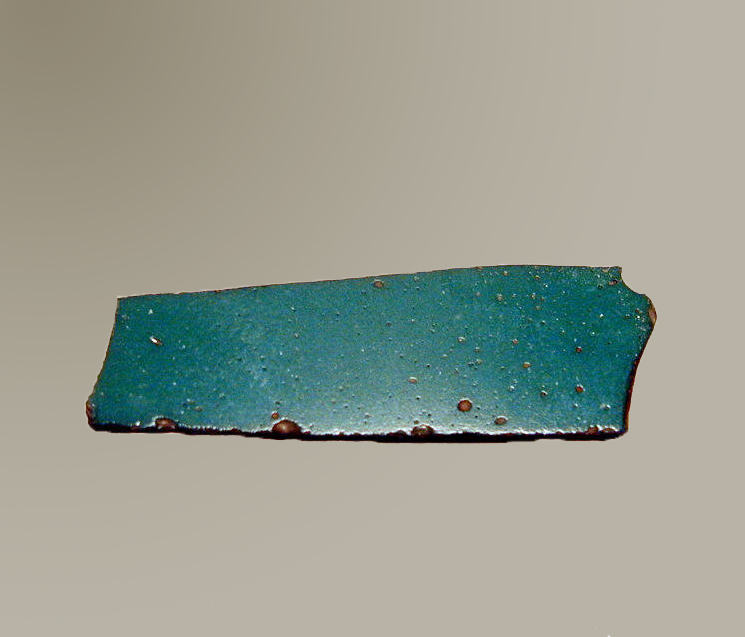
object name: fragment, monochrome inlay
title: Glass monochrome inlay fragment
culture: roman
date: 1-50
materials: glass